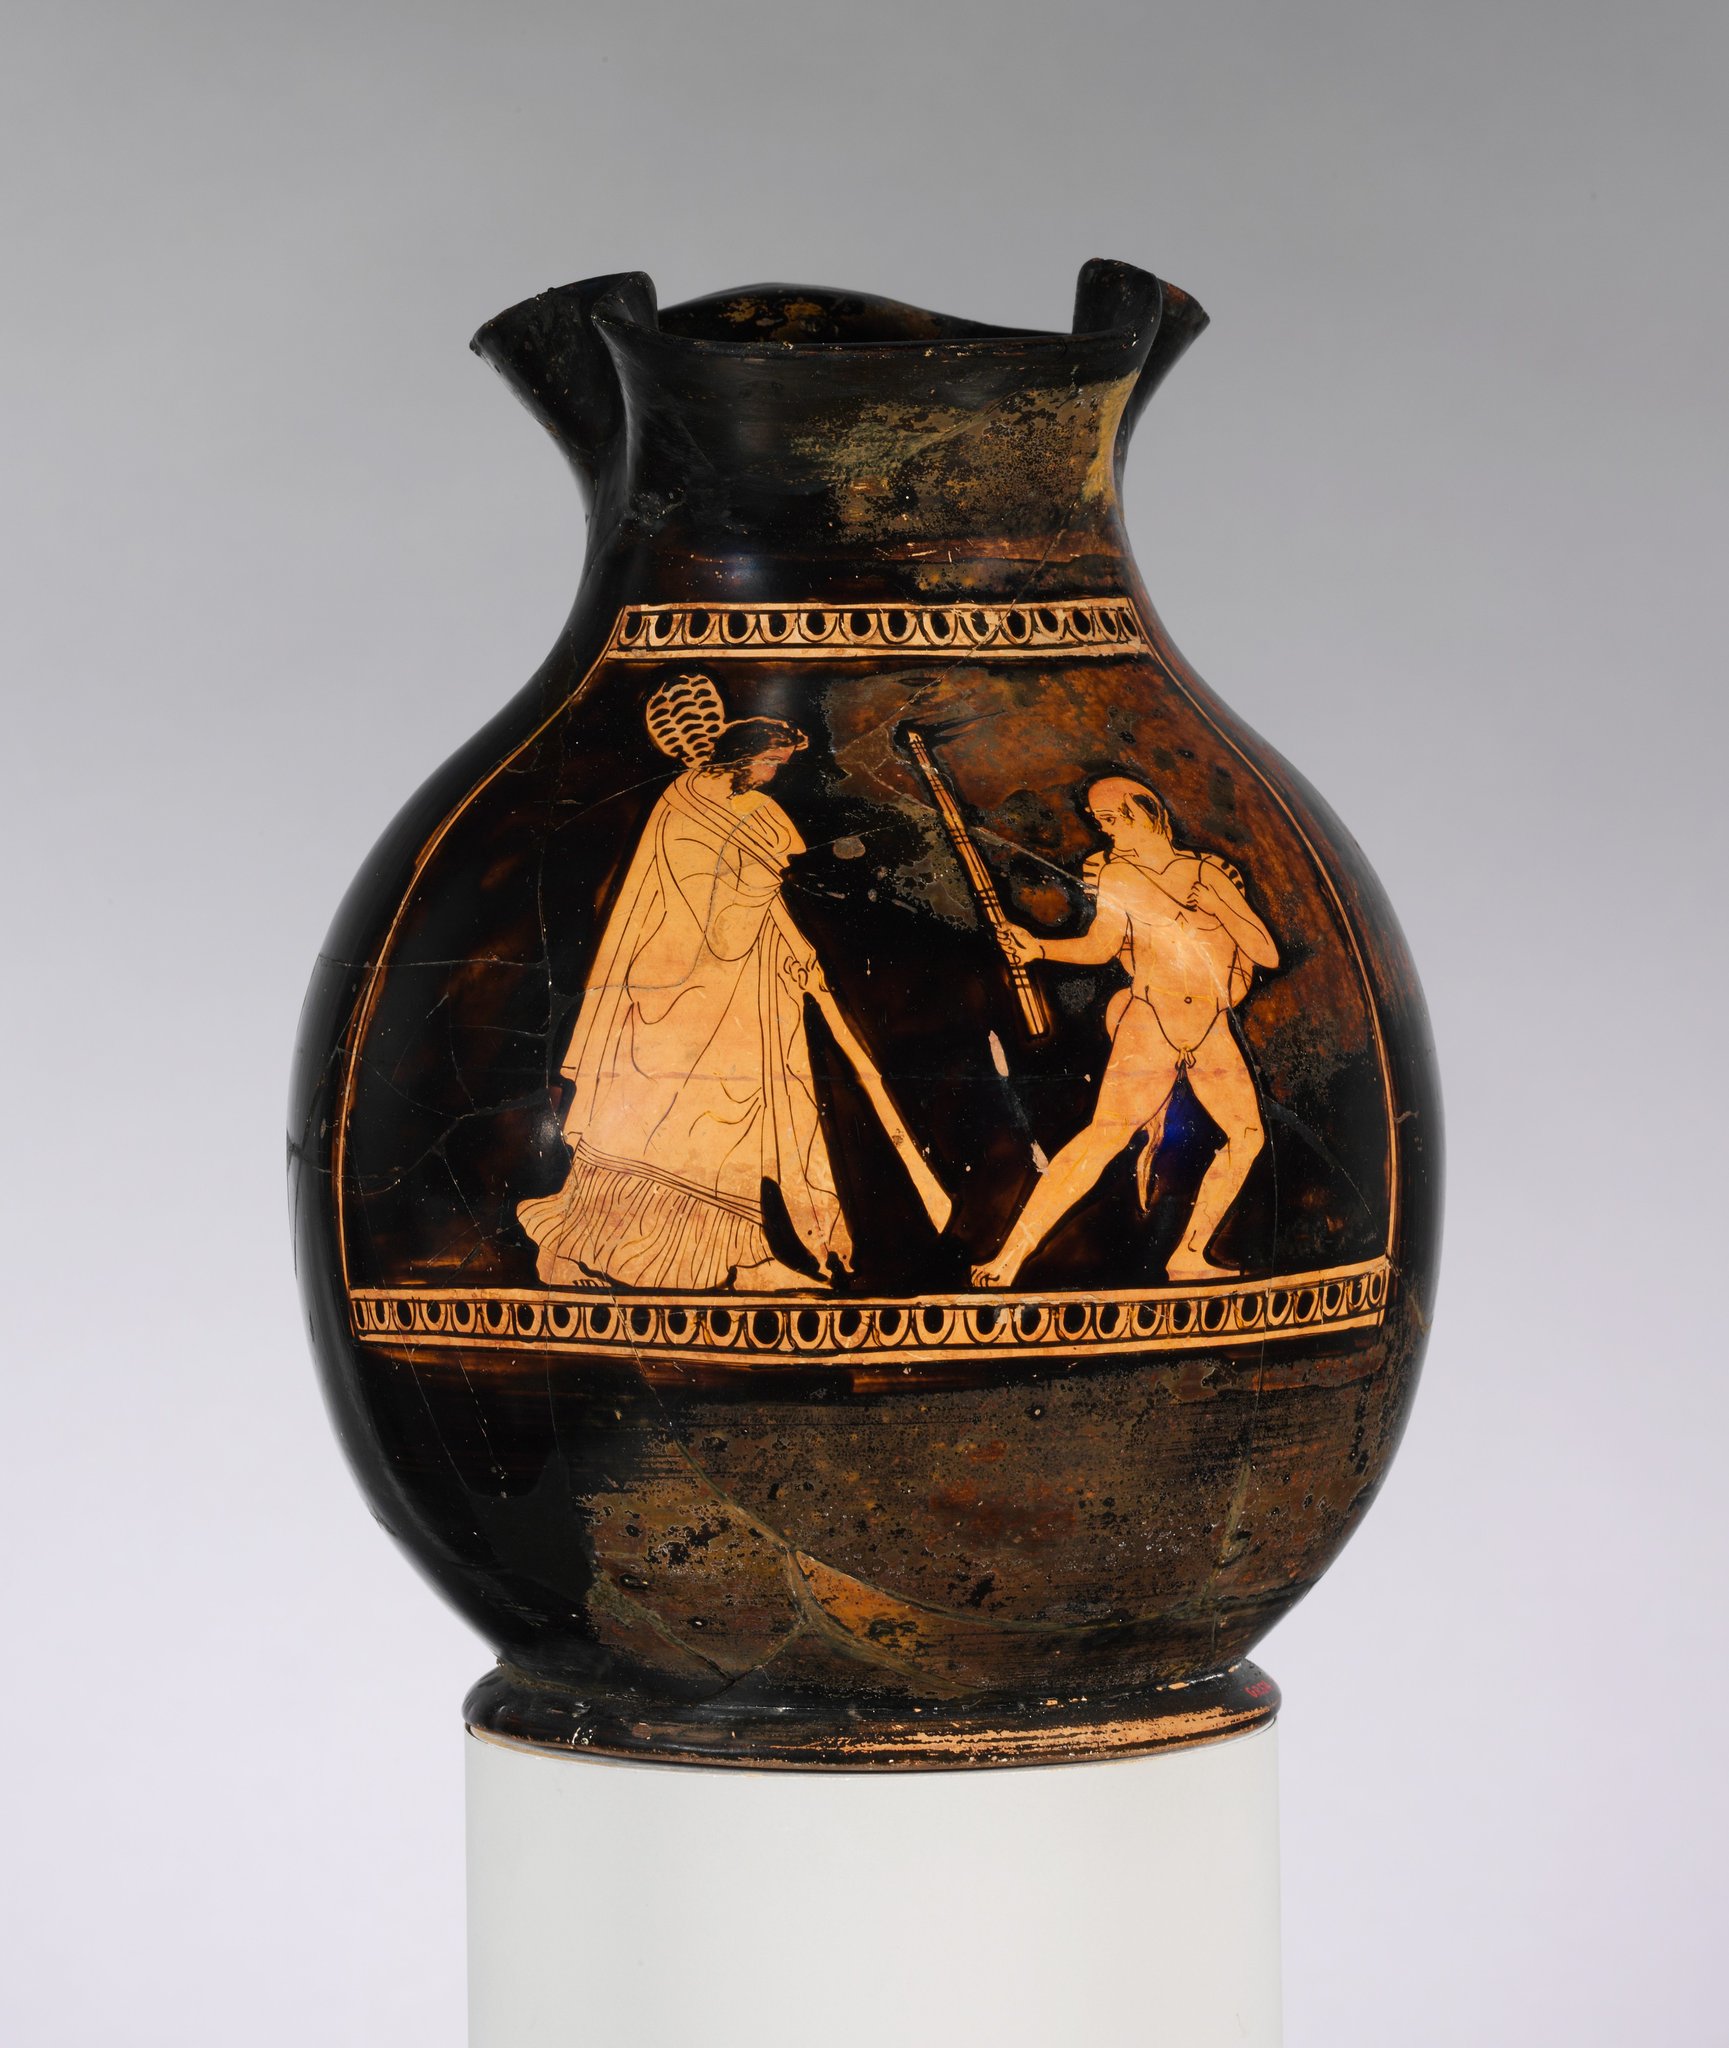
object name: oinochoe, chou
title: Terracotta oinochoe: chous (jug)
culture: greek, attic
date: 430-420 BCE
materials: terracotta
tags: women,dionysus,satyrs